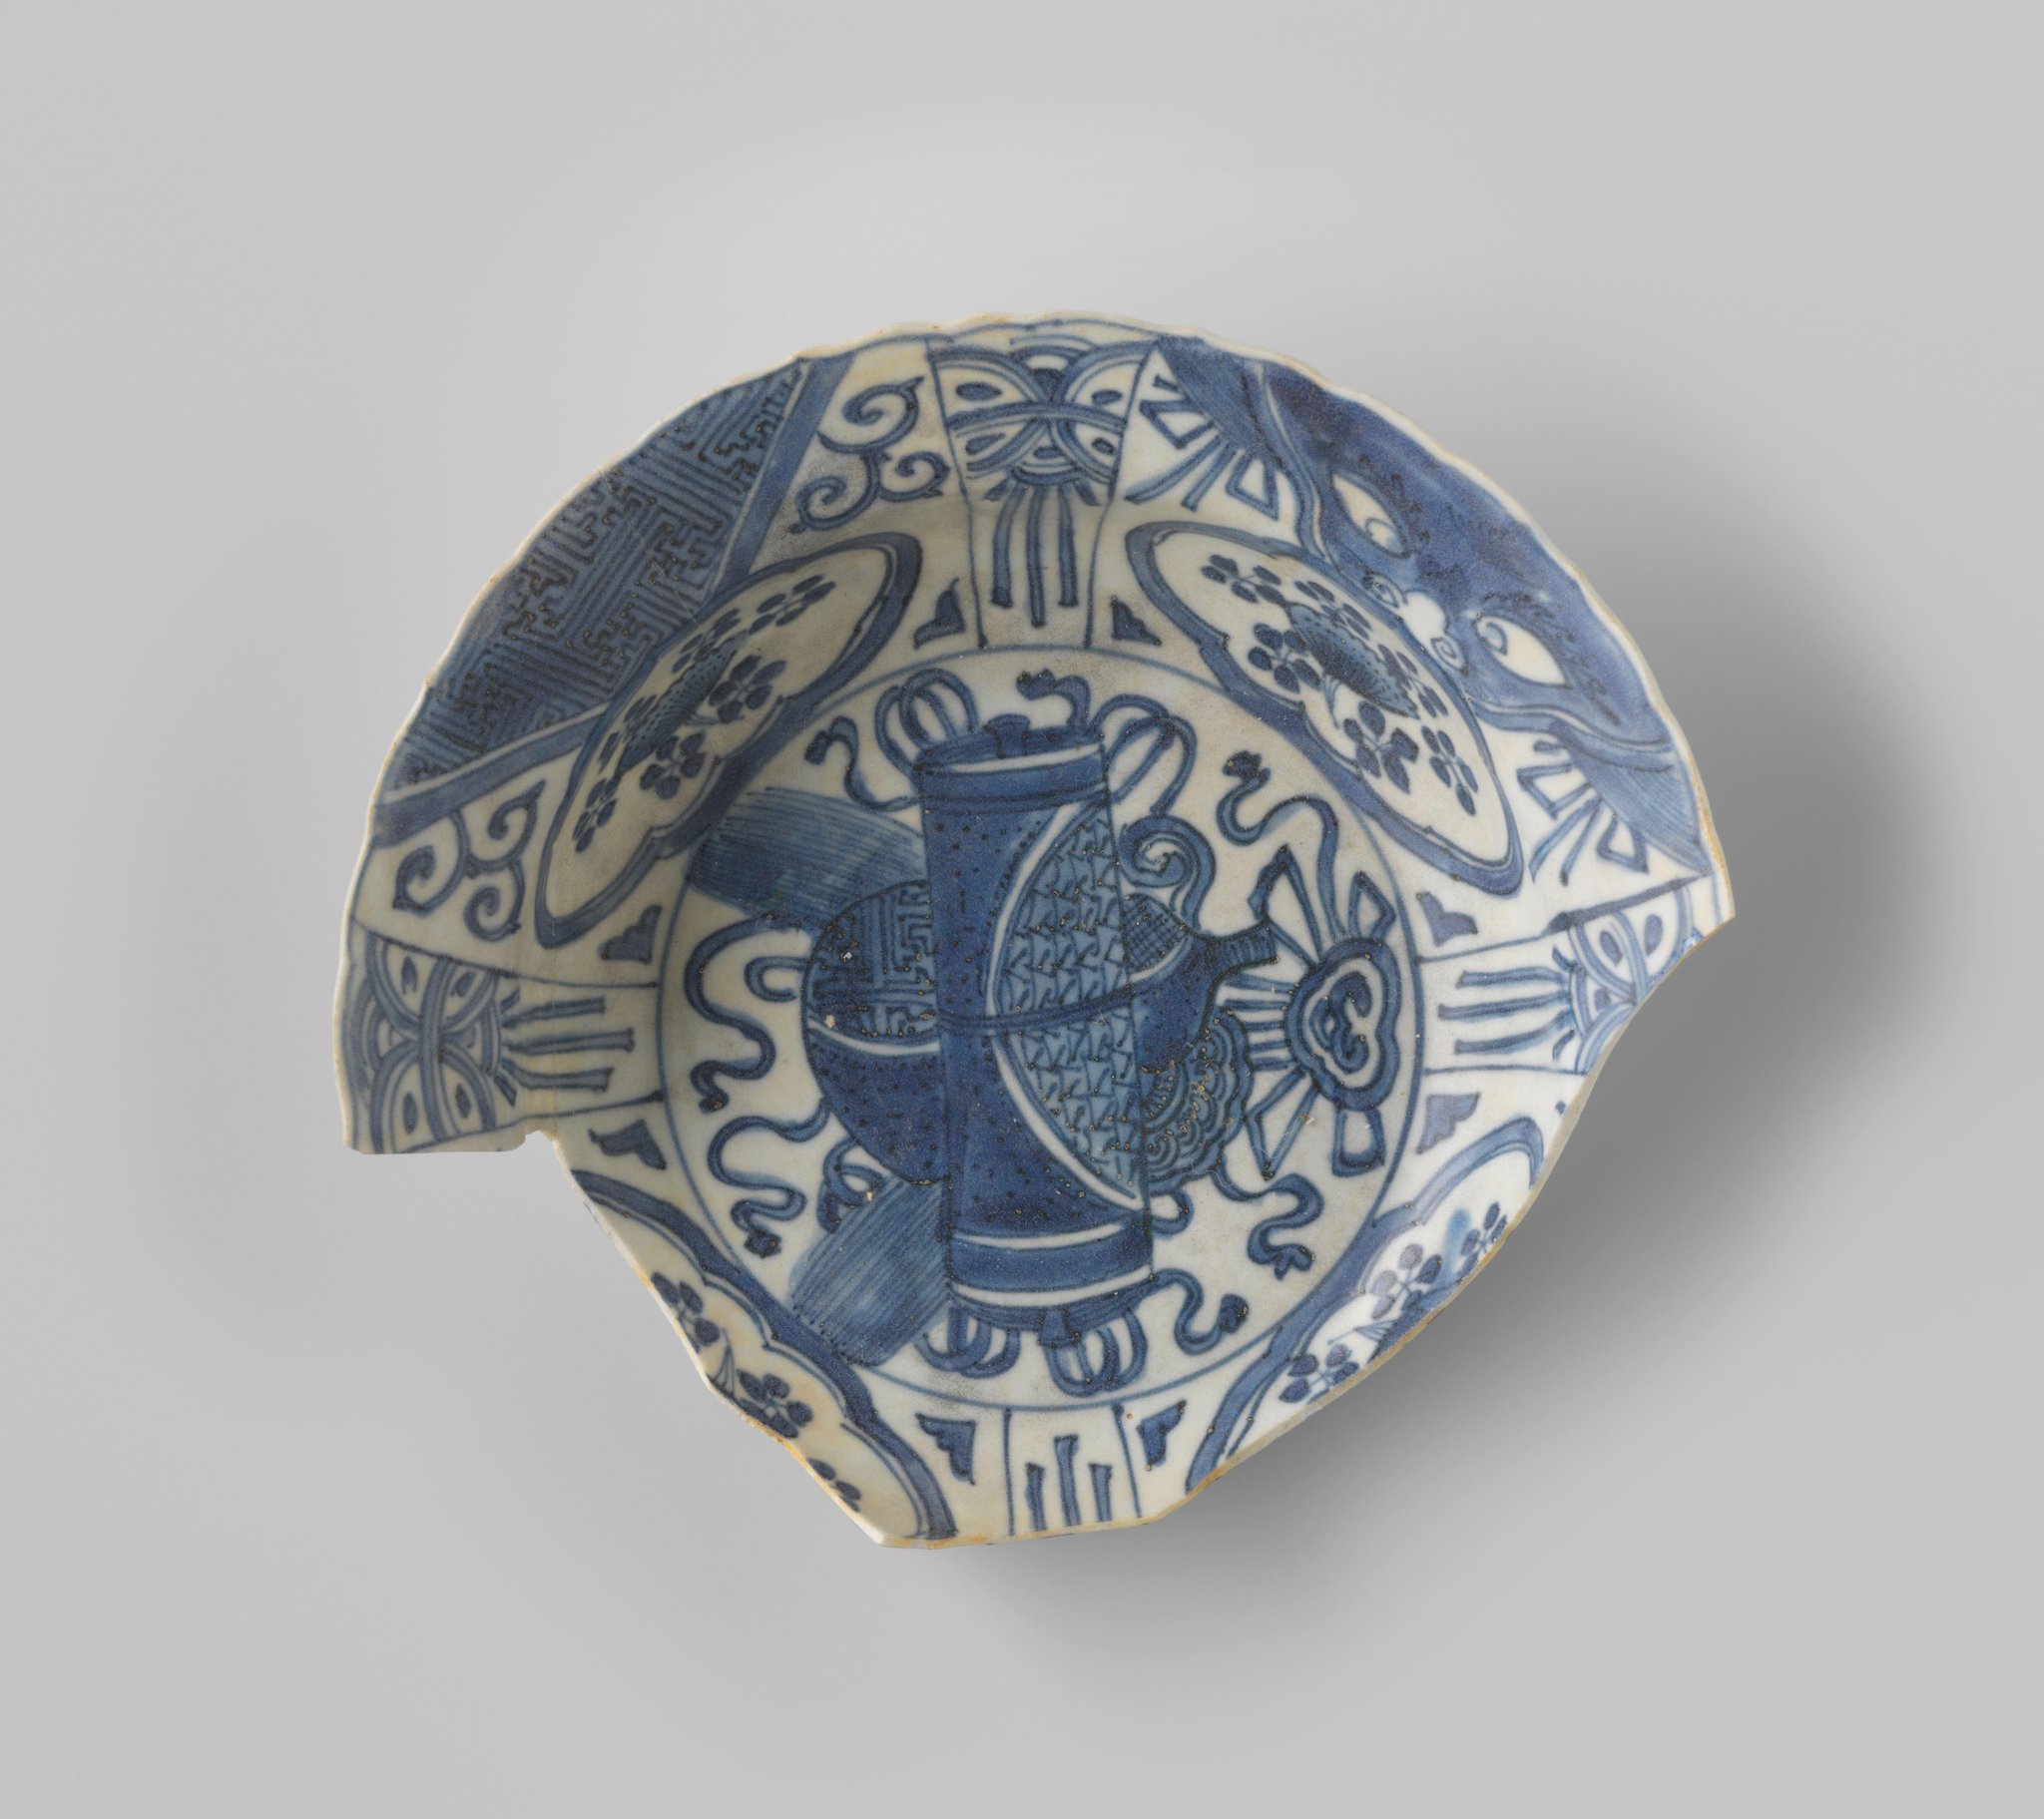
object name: deep dish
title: Diep bord uit V.O.C.-schip de 'Witte Leeuw'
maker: Anonymous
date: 1613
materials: bone china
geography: jingdezhen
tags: verenigde oostindische compagnie, sint-helena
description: A bowl with a flattened rim. Taotie mask and/or borders with diaper patterns. A central decoration of a combination of symbols. Panels decorated with flowers.